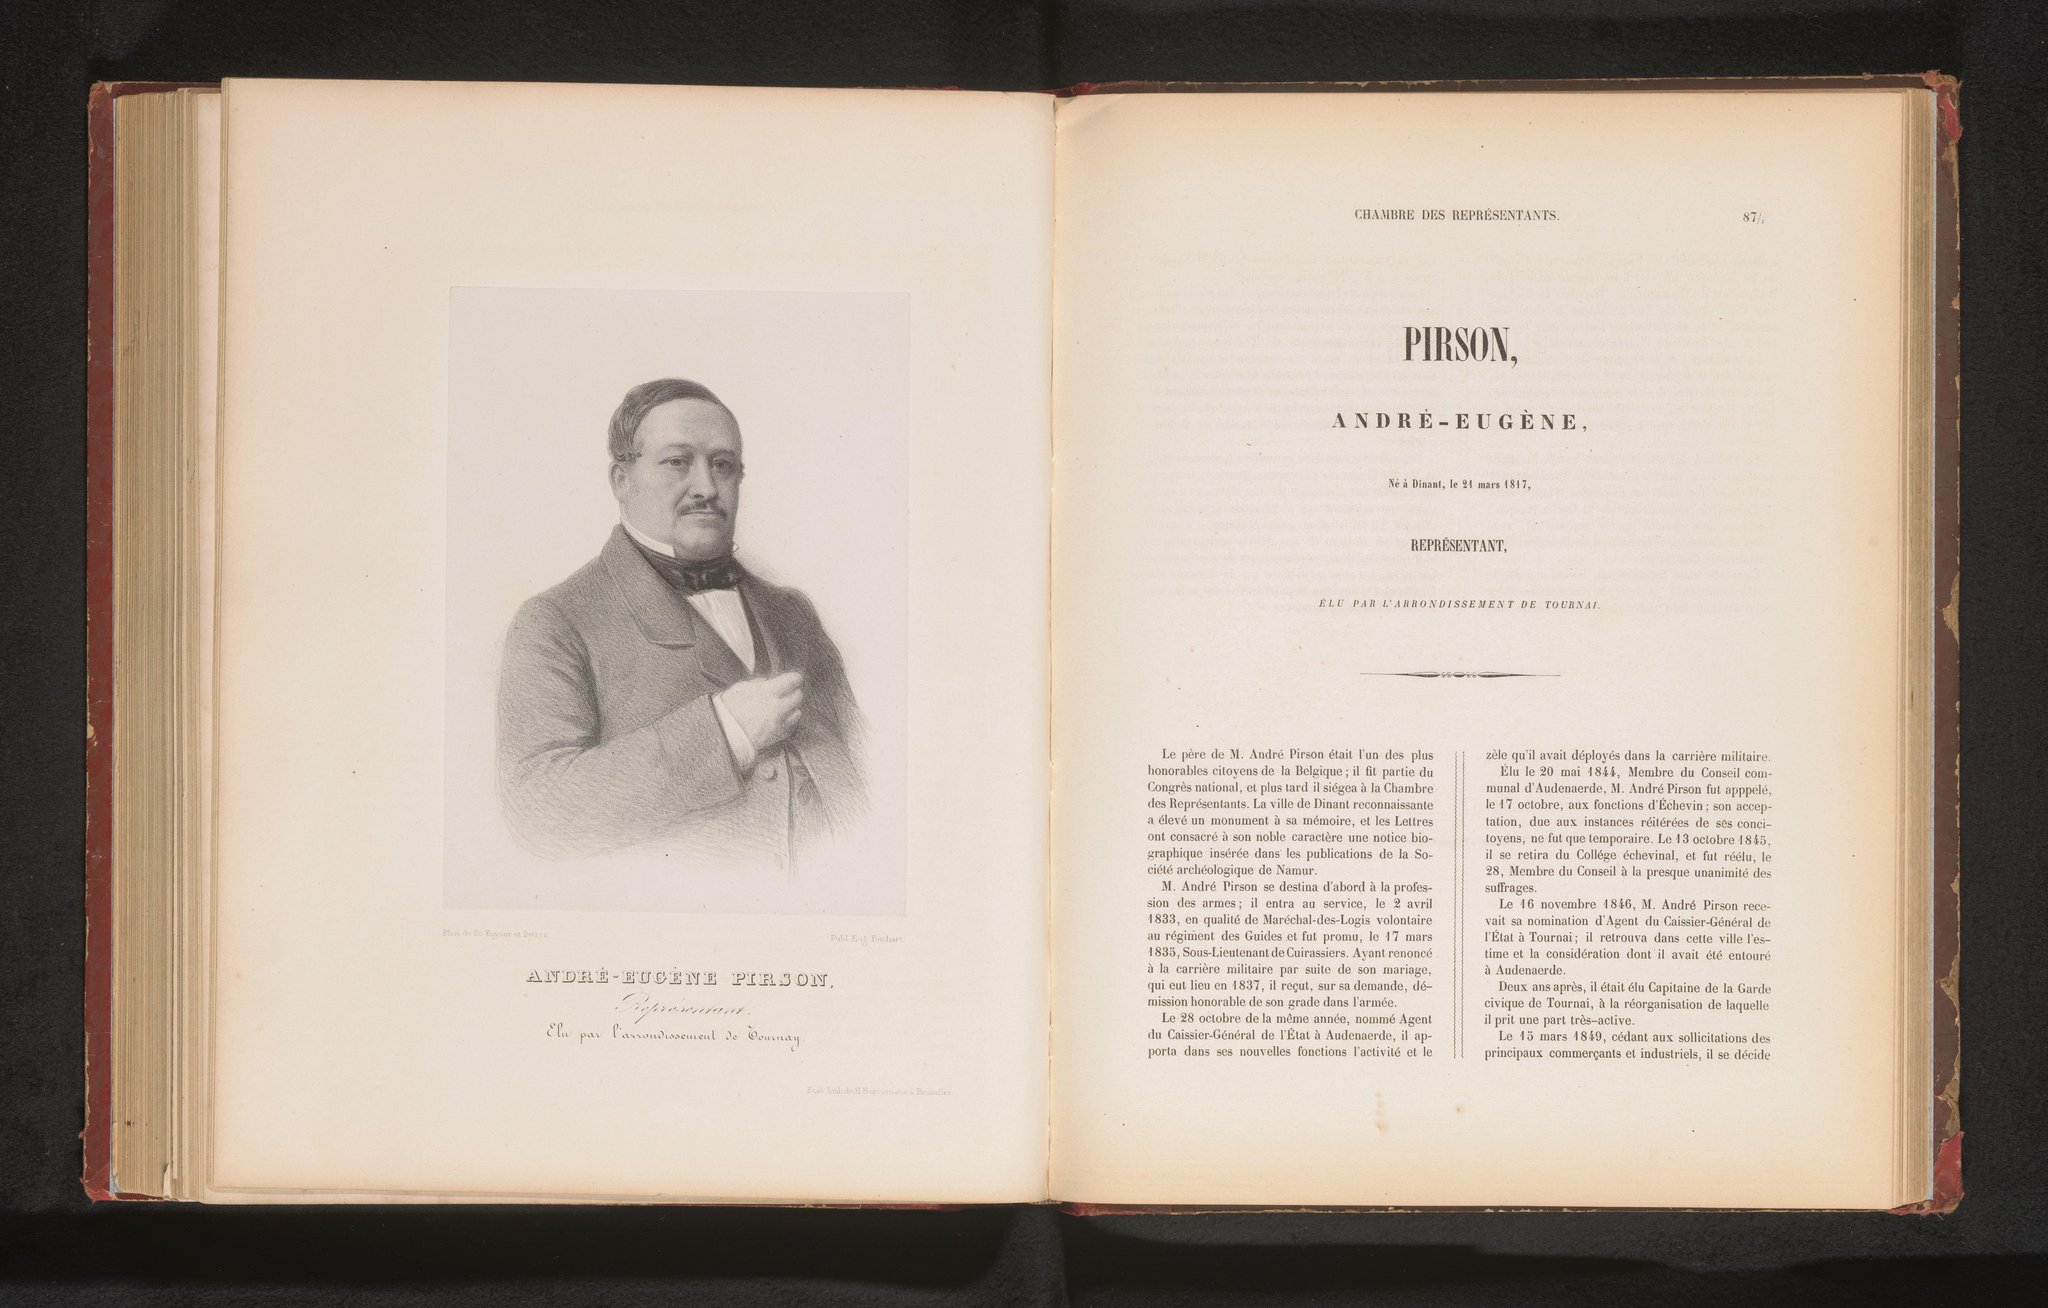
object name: page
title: André-Eugéne Pirson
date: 1853-1858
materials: paper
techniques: lithograph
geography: brussels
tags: brussels, politician, historical persons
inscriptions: inscription: ‘Représentant,/ Elu par l'arrondissement de Tournay.’